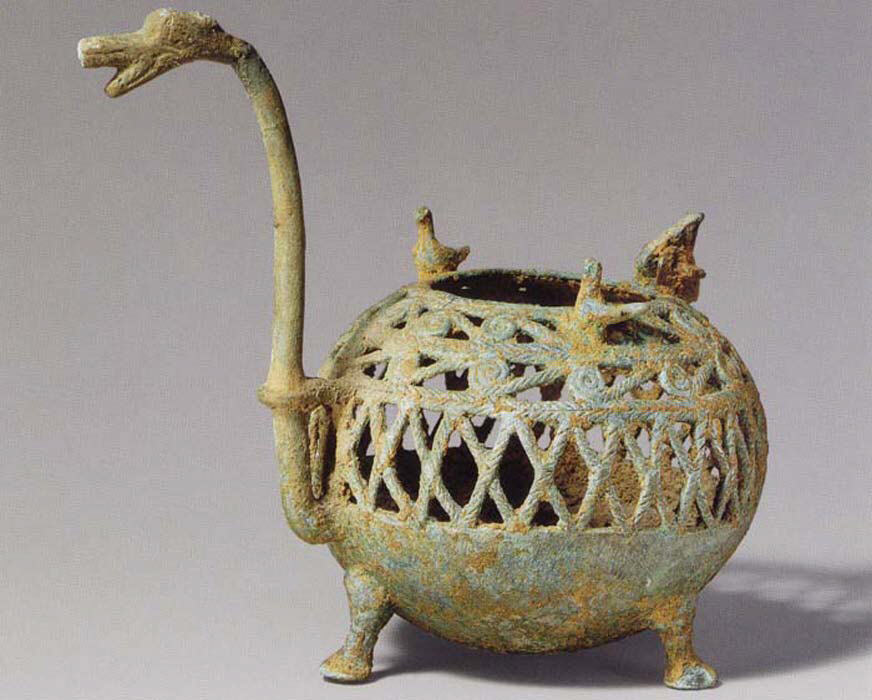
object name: incense burner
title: Incense Burner with Dragon Spout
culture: vietnamese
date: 1-300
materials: bronze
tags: dragons